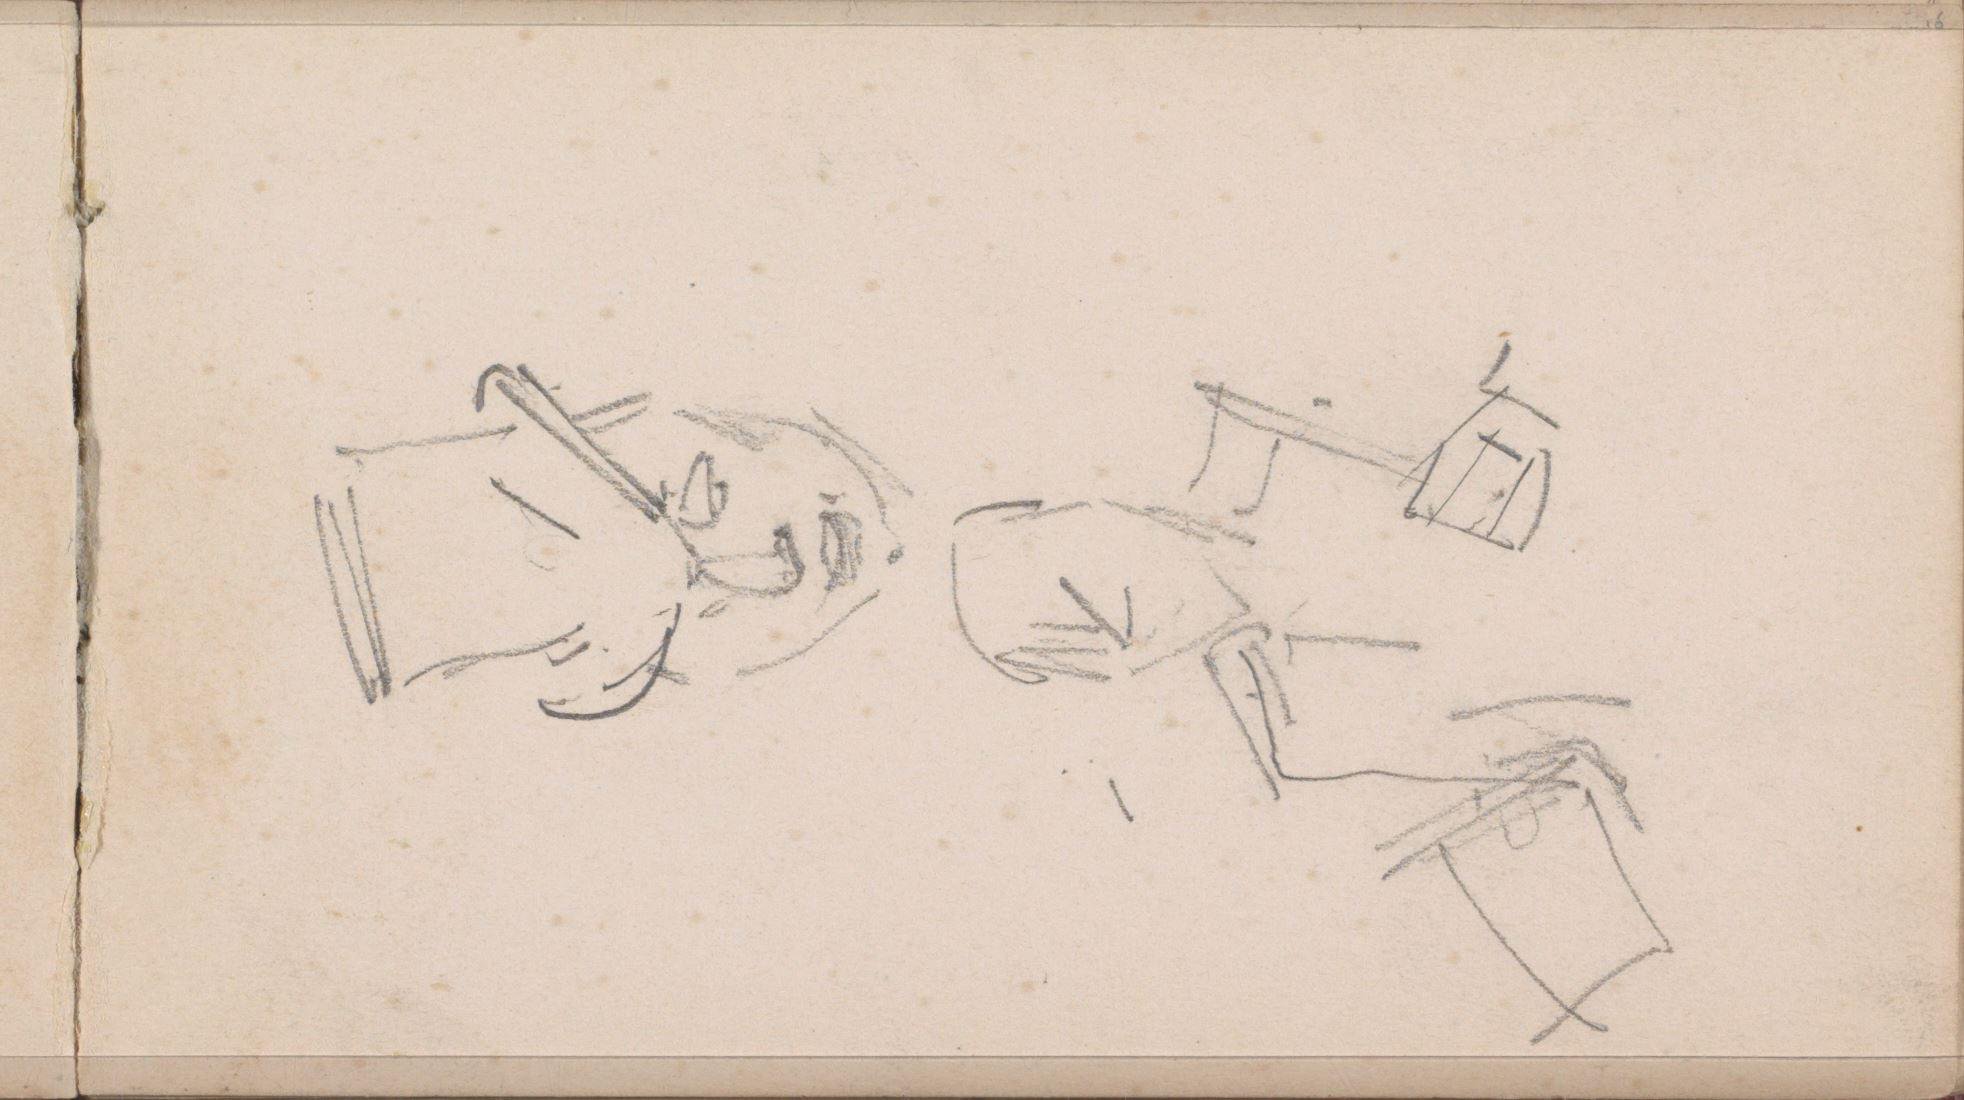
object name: sketchbook leaf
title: Man en een mannenhoofd met hoge hoed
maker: george hendrik breitner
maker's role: draughtsman, painter, print maker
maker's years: 1857-1923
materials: paper, pencil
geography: amsterdam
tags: head (human), adult man, head-gear: top hat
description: Pagina 16 uit een schetsboek met 32 bladen.